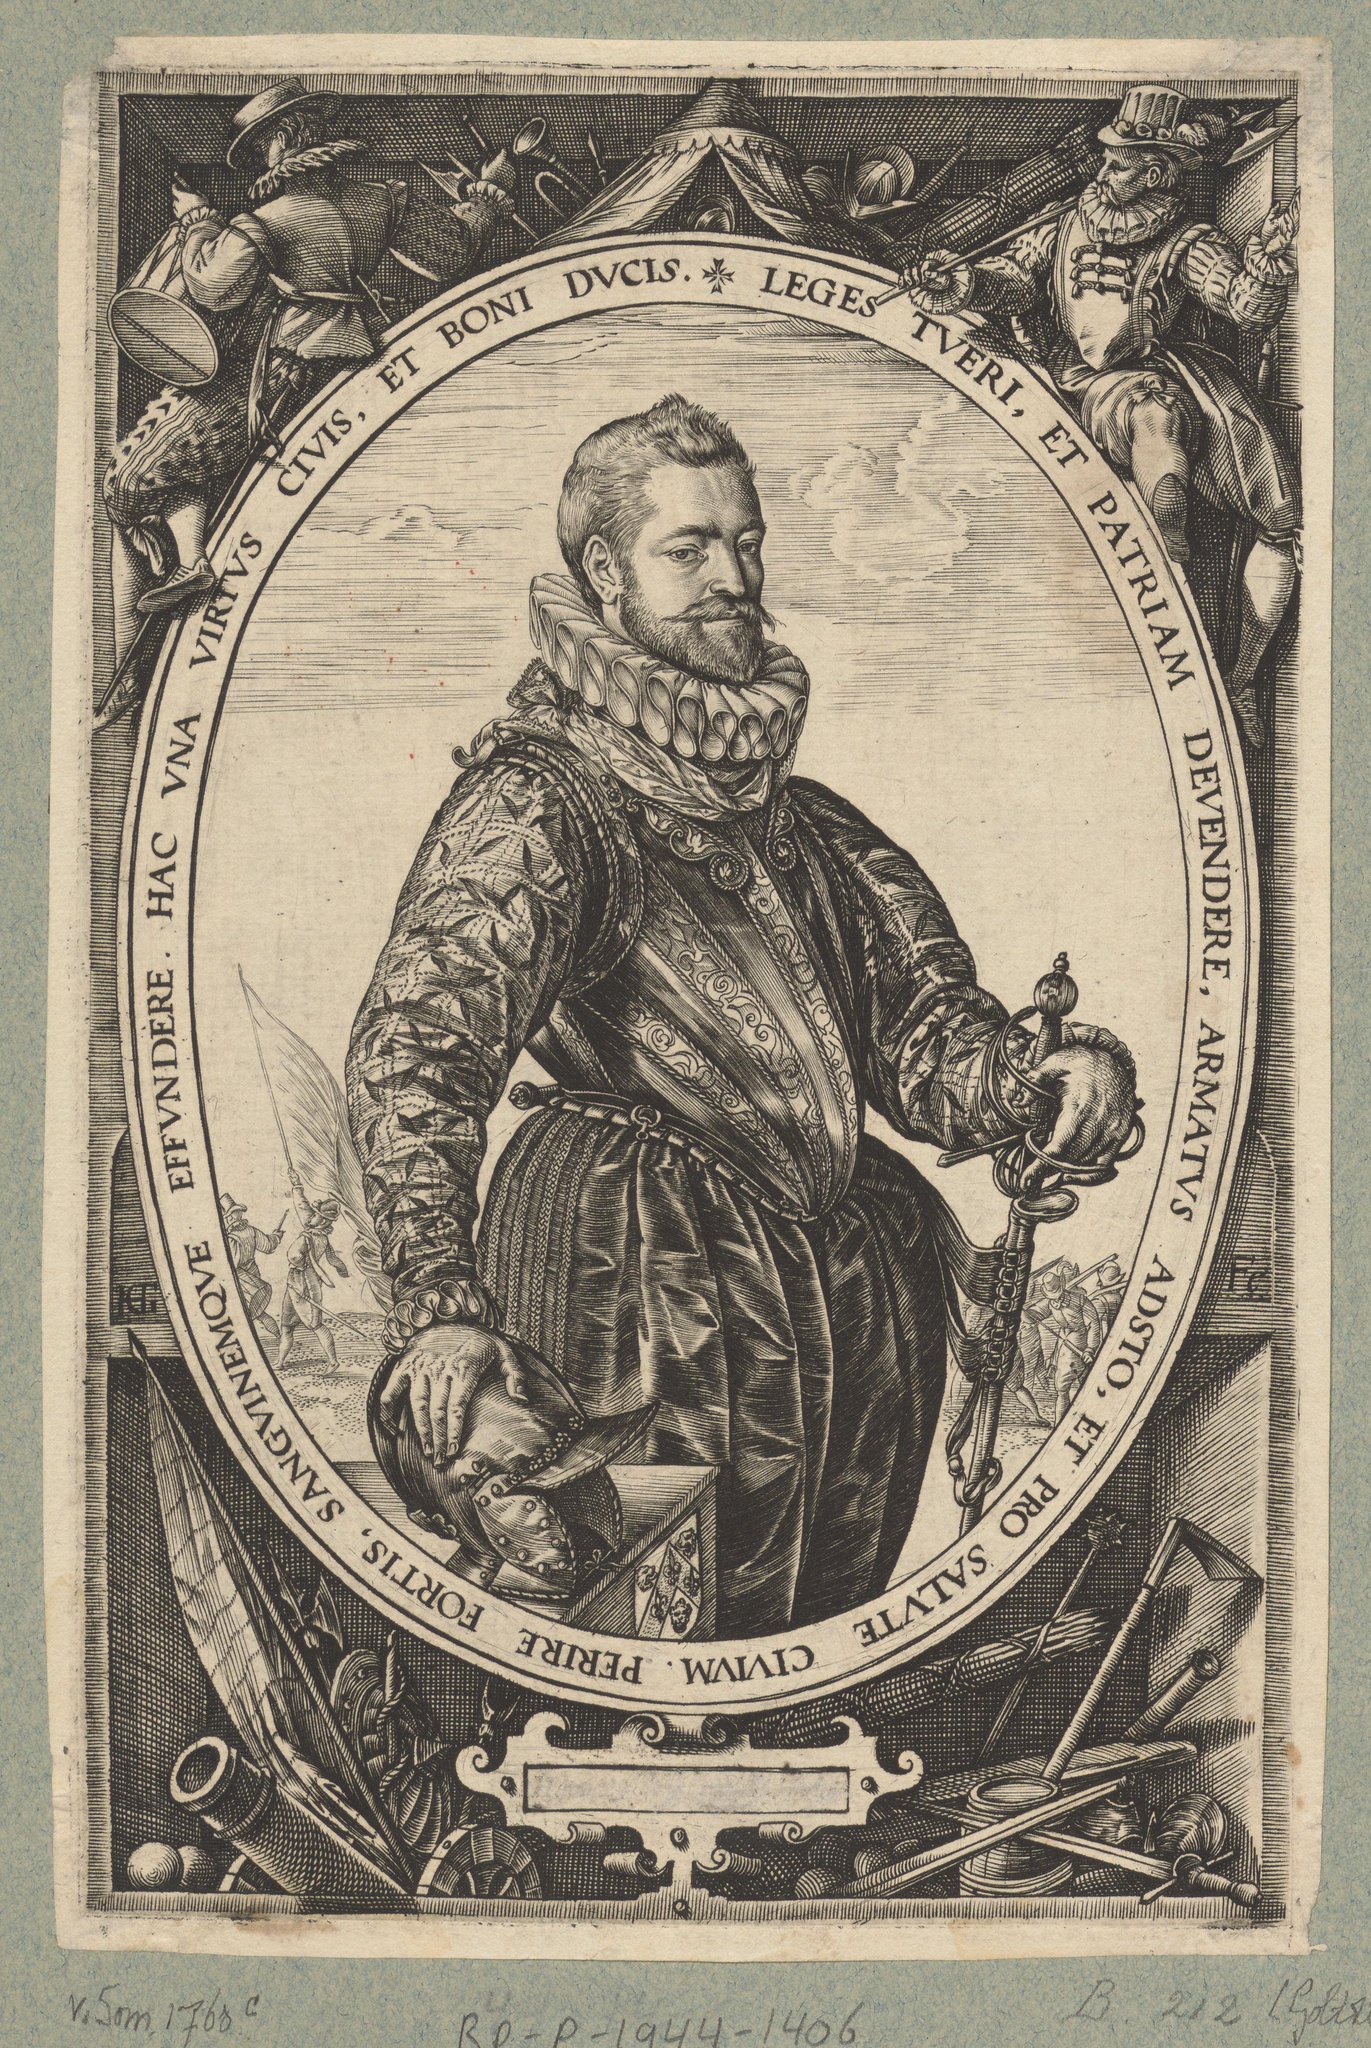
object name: print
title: Portret van Jacques de la Faille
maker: hendrick goltzius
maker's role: draughtsman, painter, print maker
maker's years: 1558-1617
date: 1580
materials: paper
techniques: engraving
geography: haarlem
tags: helmet, (military) camp with tents, historical persons, hacking and thrusting weapons: sword, drum (musical instrument), warfare; military affairs (+ citizen soldiery, civil guard, citizen militia), helved weapons, polearms (for striking, hacking, thrusting): halberd, merchant, salesman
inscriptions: collector's mark: Lugt 240, collector's mark: Lugt 3937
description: Deze prent is waarschijnlijk de vijfde staat genoemd in Hollstein. In de New Hollstein wordt deze staat niet meer vermeld omdat hij gelijk zou zijn aan de derde staat: op deze prent is echter duidelijk de verwijderde naam van Harmen Adolfsz. zichtbaar.